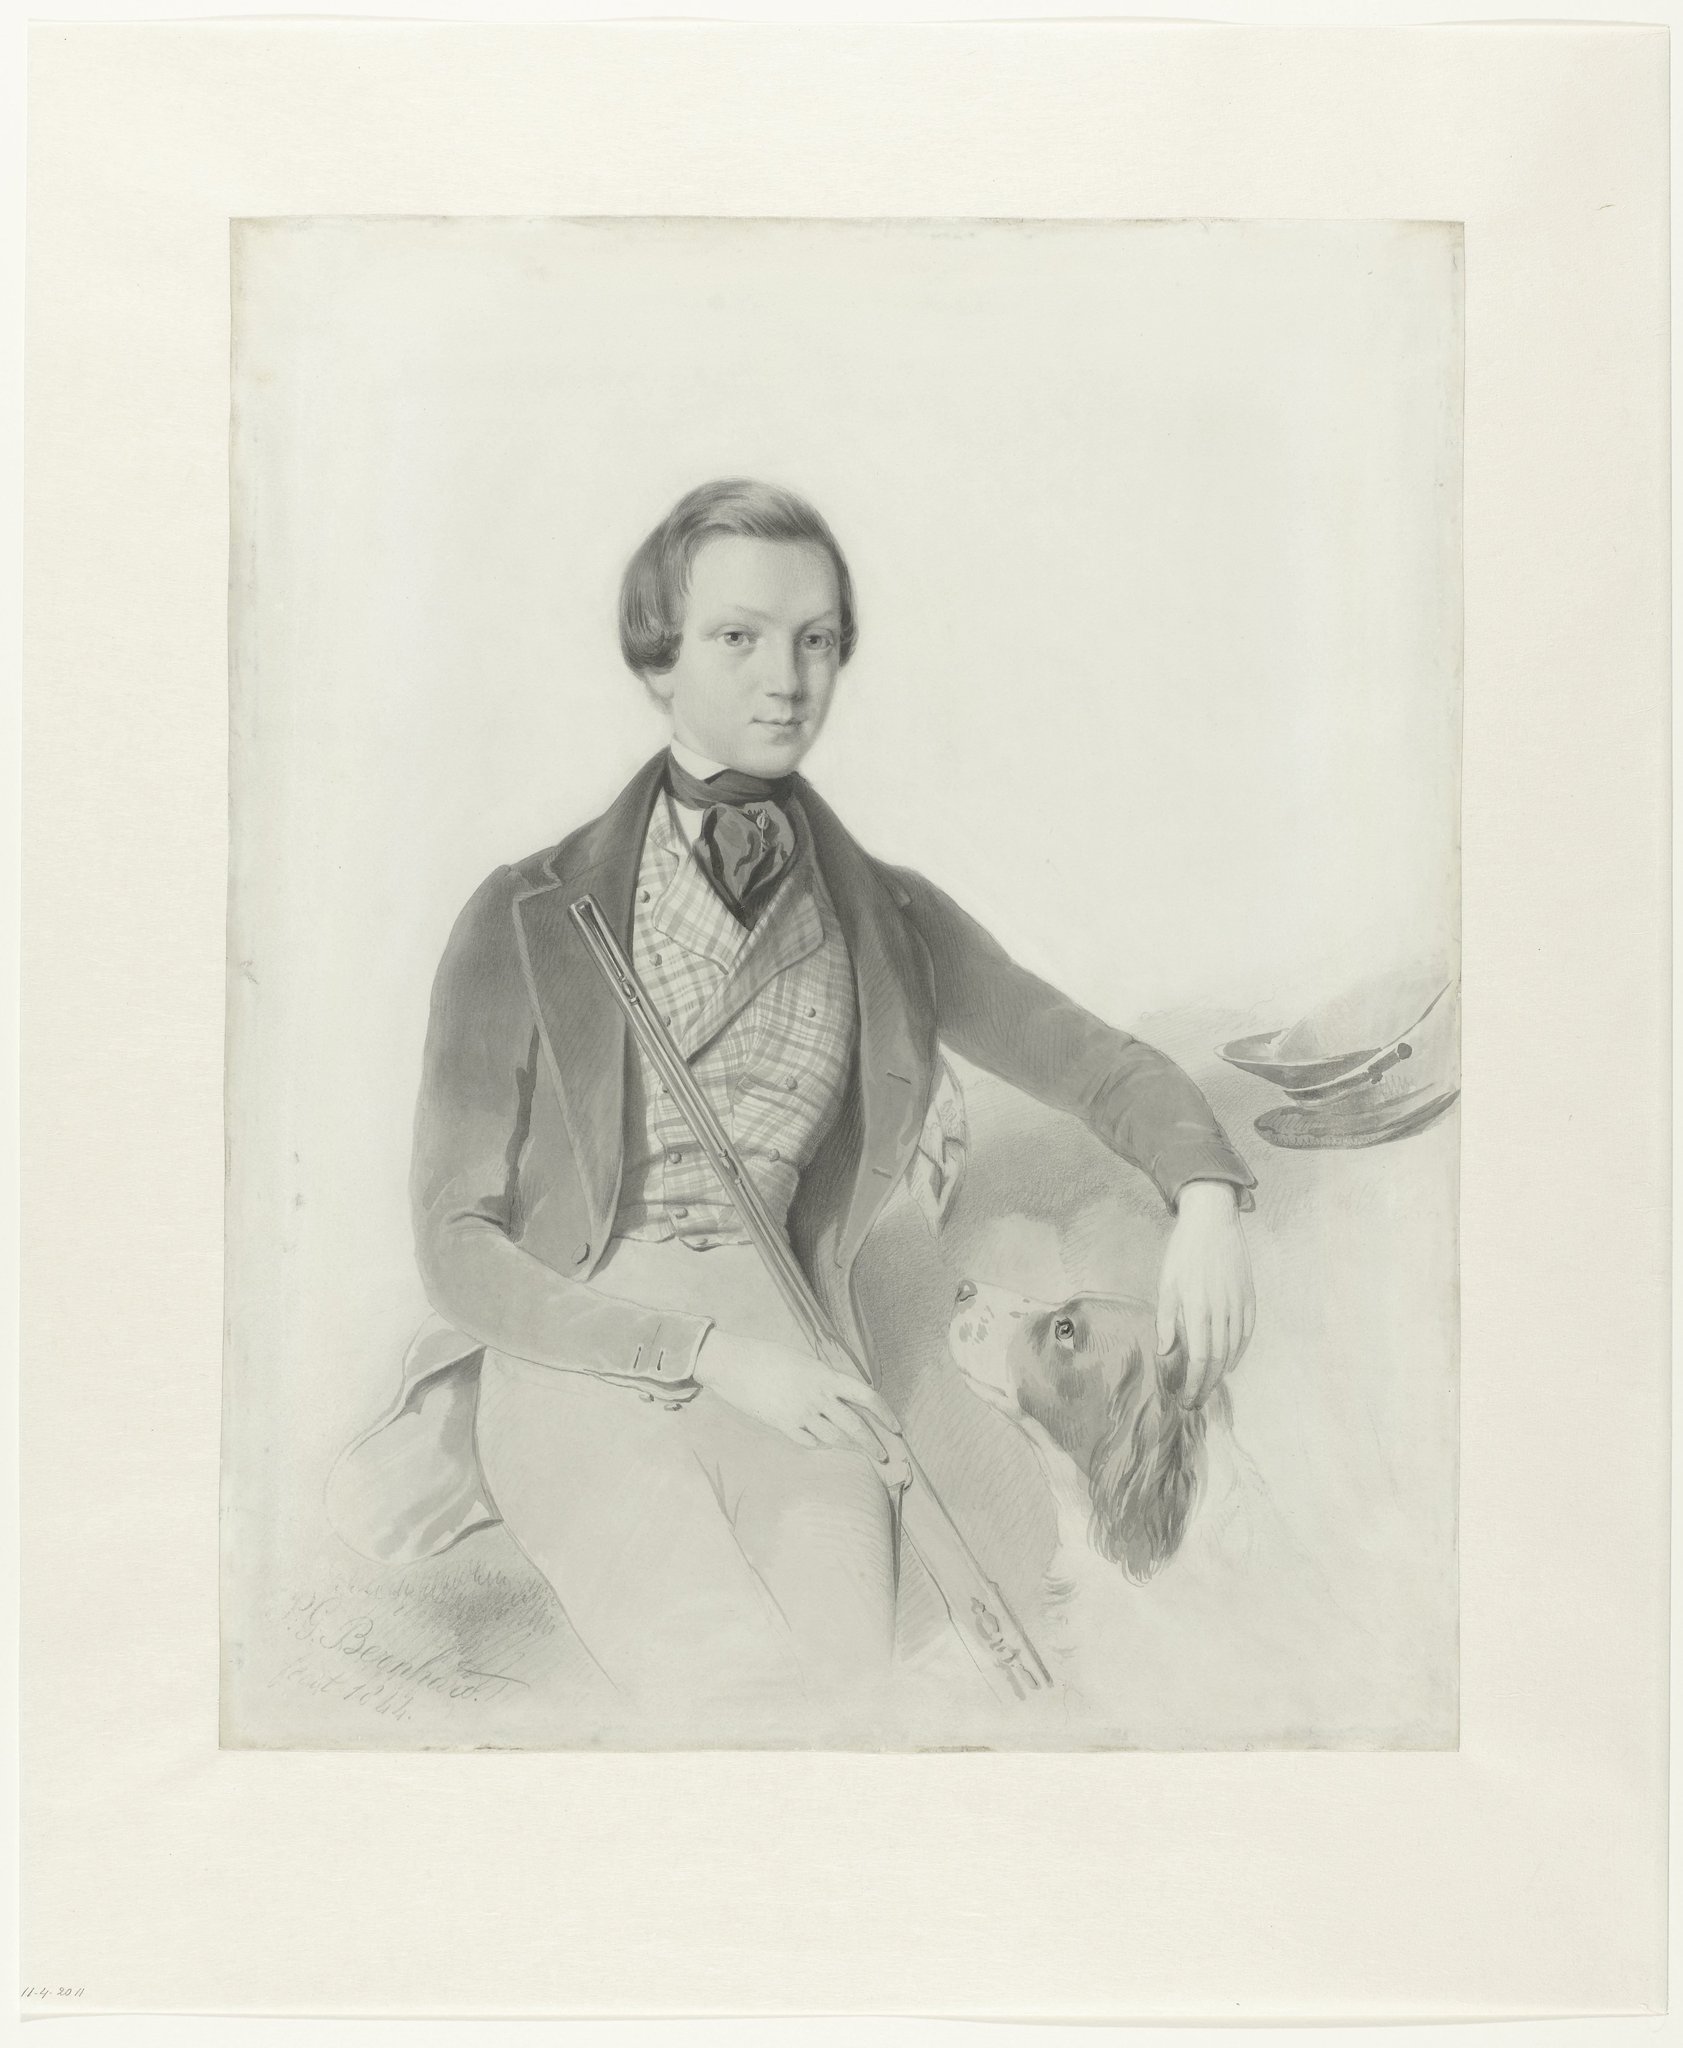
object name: drawing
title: Portret van baron François René Hendrik Robert Fagel op jeugdige leeftijd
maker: pieter gerardus bernhard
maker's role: print maker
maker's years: 1813-1880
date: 1844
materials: paper, pencil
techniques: brush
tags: the hague, historical persons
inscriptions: date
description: Jonge man met geweer (?), leunend tegenverhoging waarop zijn pet ligt. Zijn linkerhand rust op de kop van een hond.